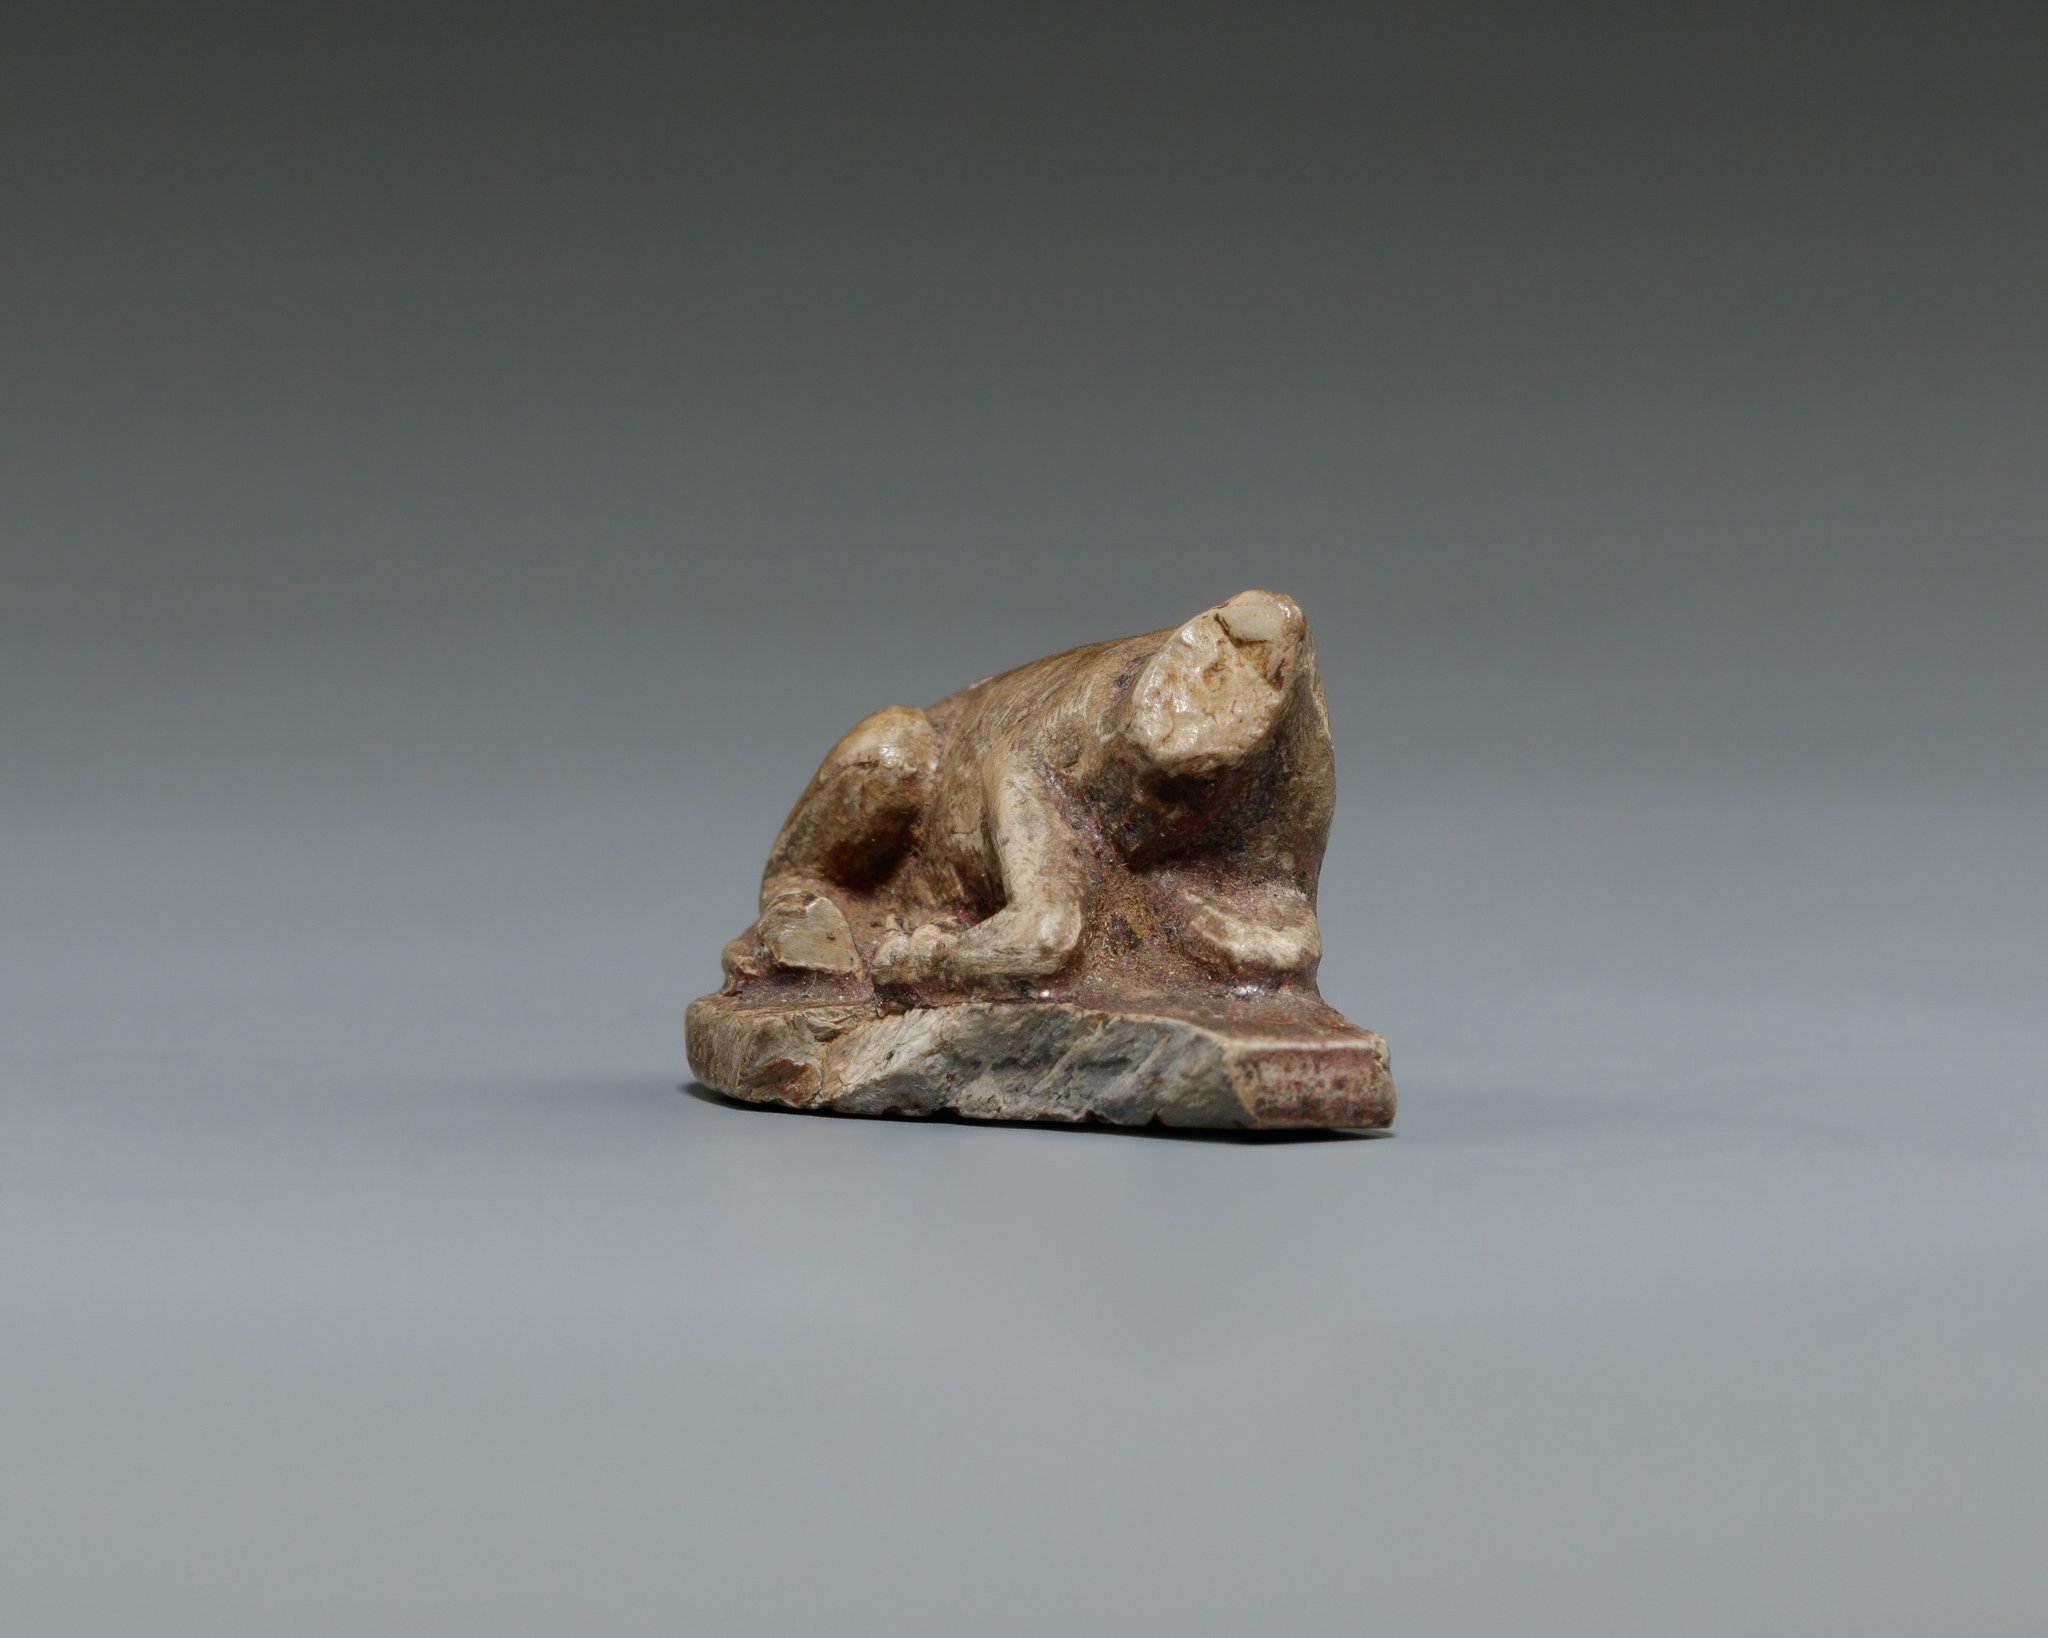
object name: seal, nebhepetre mentuhotep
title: Seal with names of Nebhepetre Mentuhotep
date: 2030-1640 BCE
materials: stone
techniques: glazing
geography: egypt